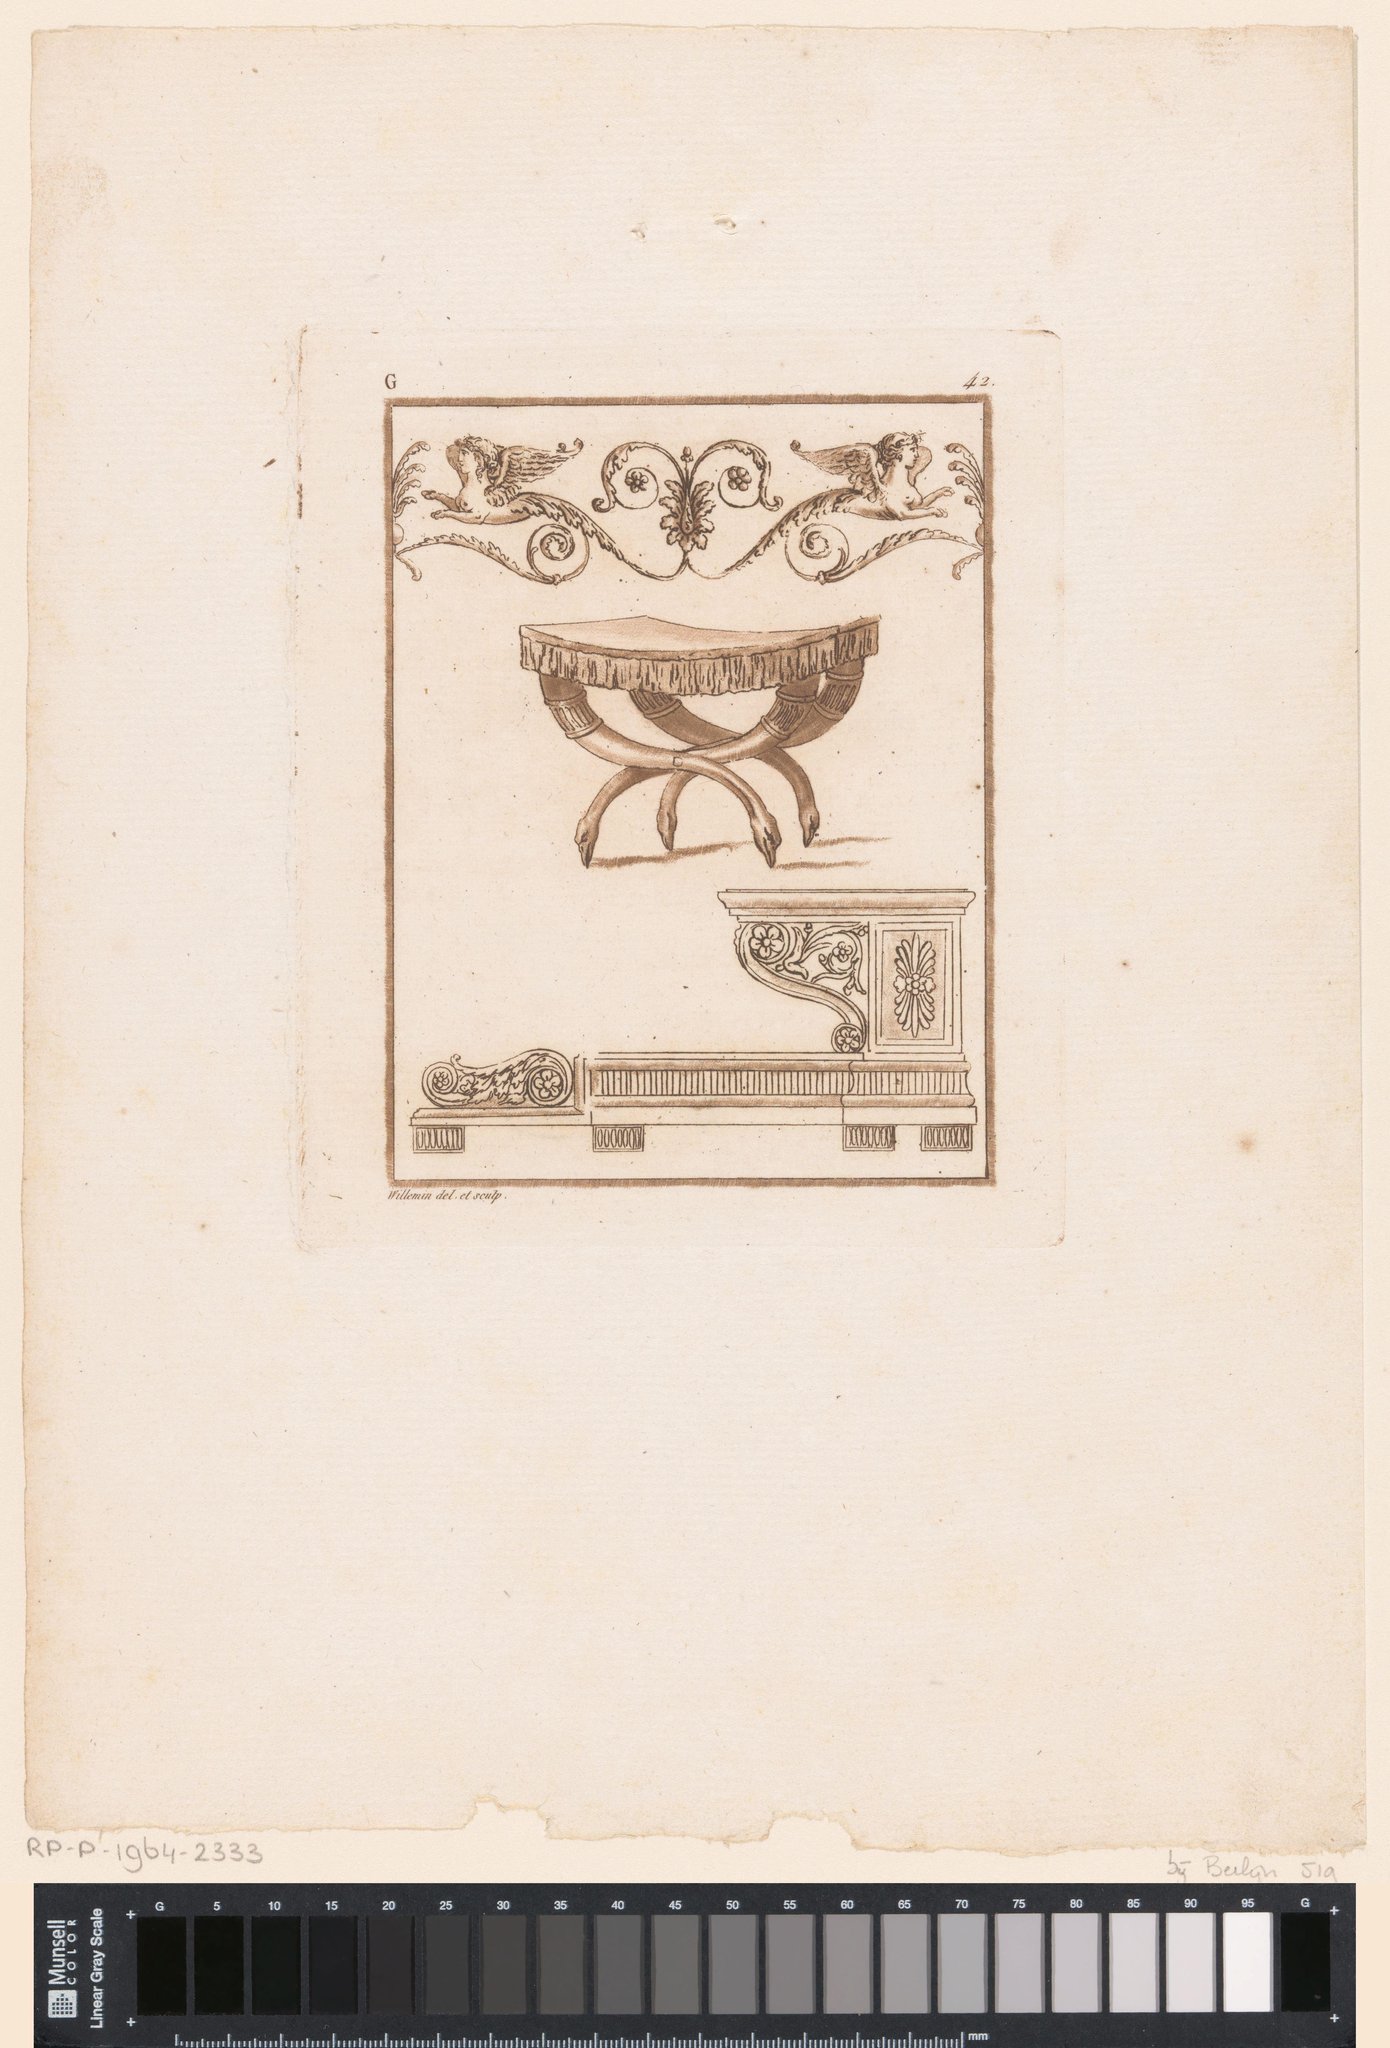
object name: ornament print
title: Bank met zwanenkoppen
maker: nicolas xavier willemin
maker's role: print maker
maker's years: 1763-1839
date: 1775-1797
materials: paper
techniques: aquatint, etching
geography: paris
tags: bench, water-birds: swan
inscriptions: collector's mark: Lugt 2760, collector's mark: Lugt 2228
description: Een kruk of (voeten)bank met zwanenkoppen als poten. Daarboven vlechtwerk met sfinxen. Aan de onderzijde een geornamenteerd meubel met blad- en bloemmotieven.